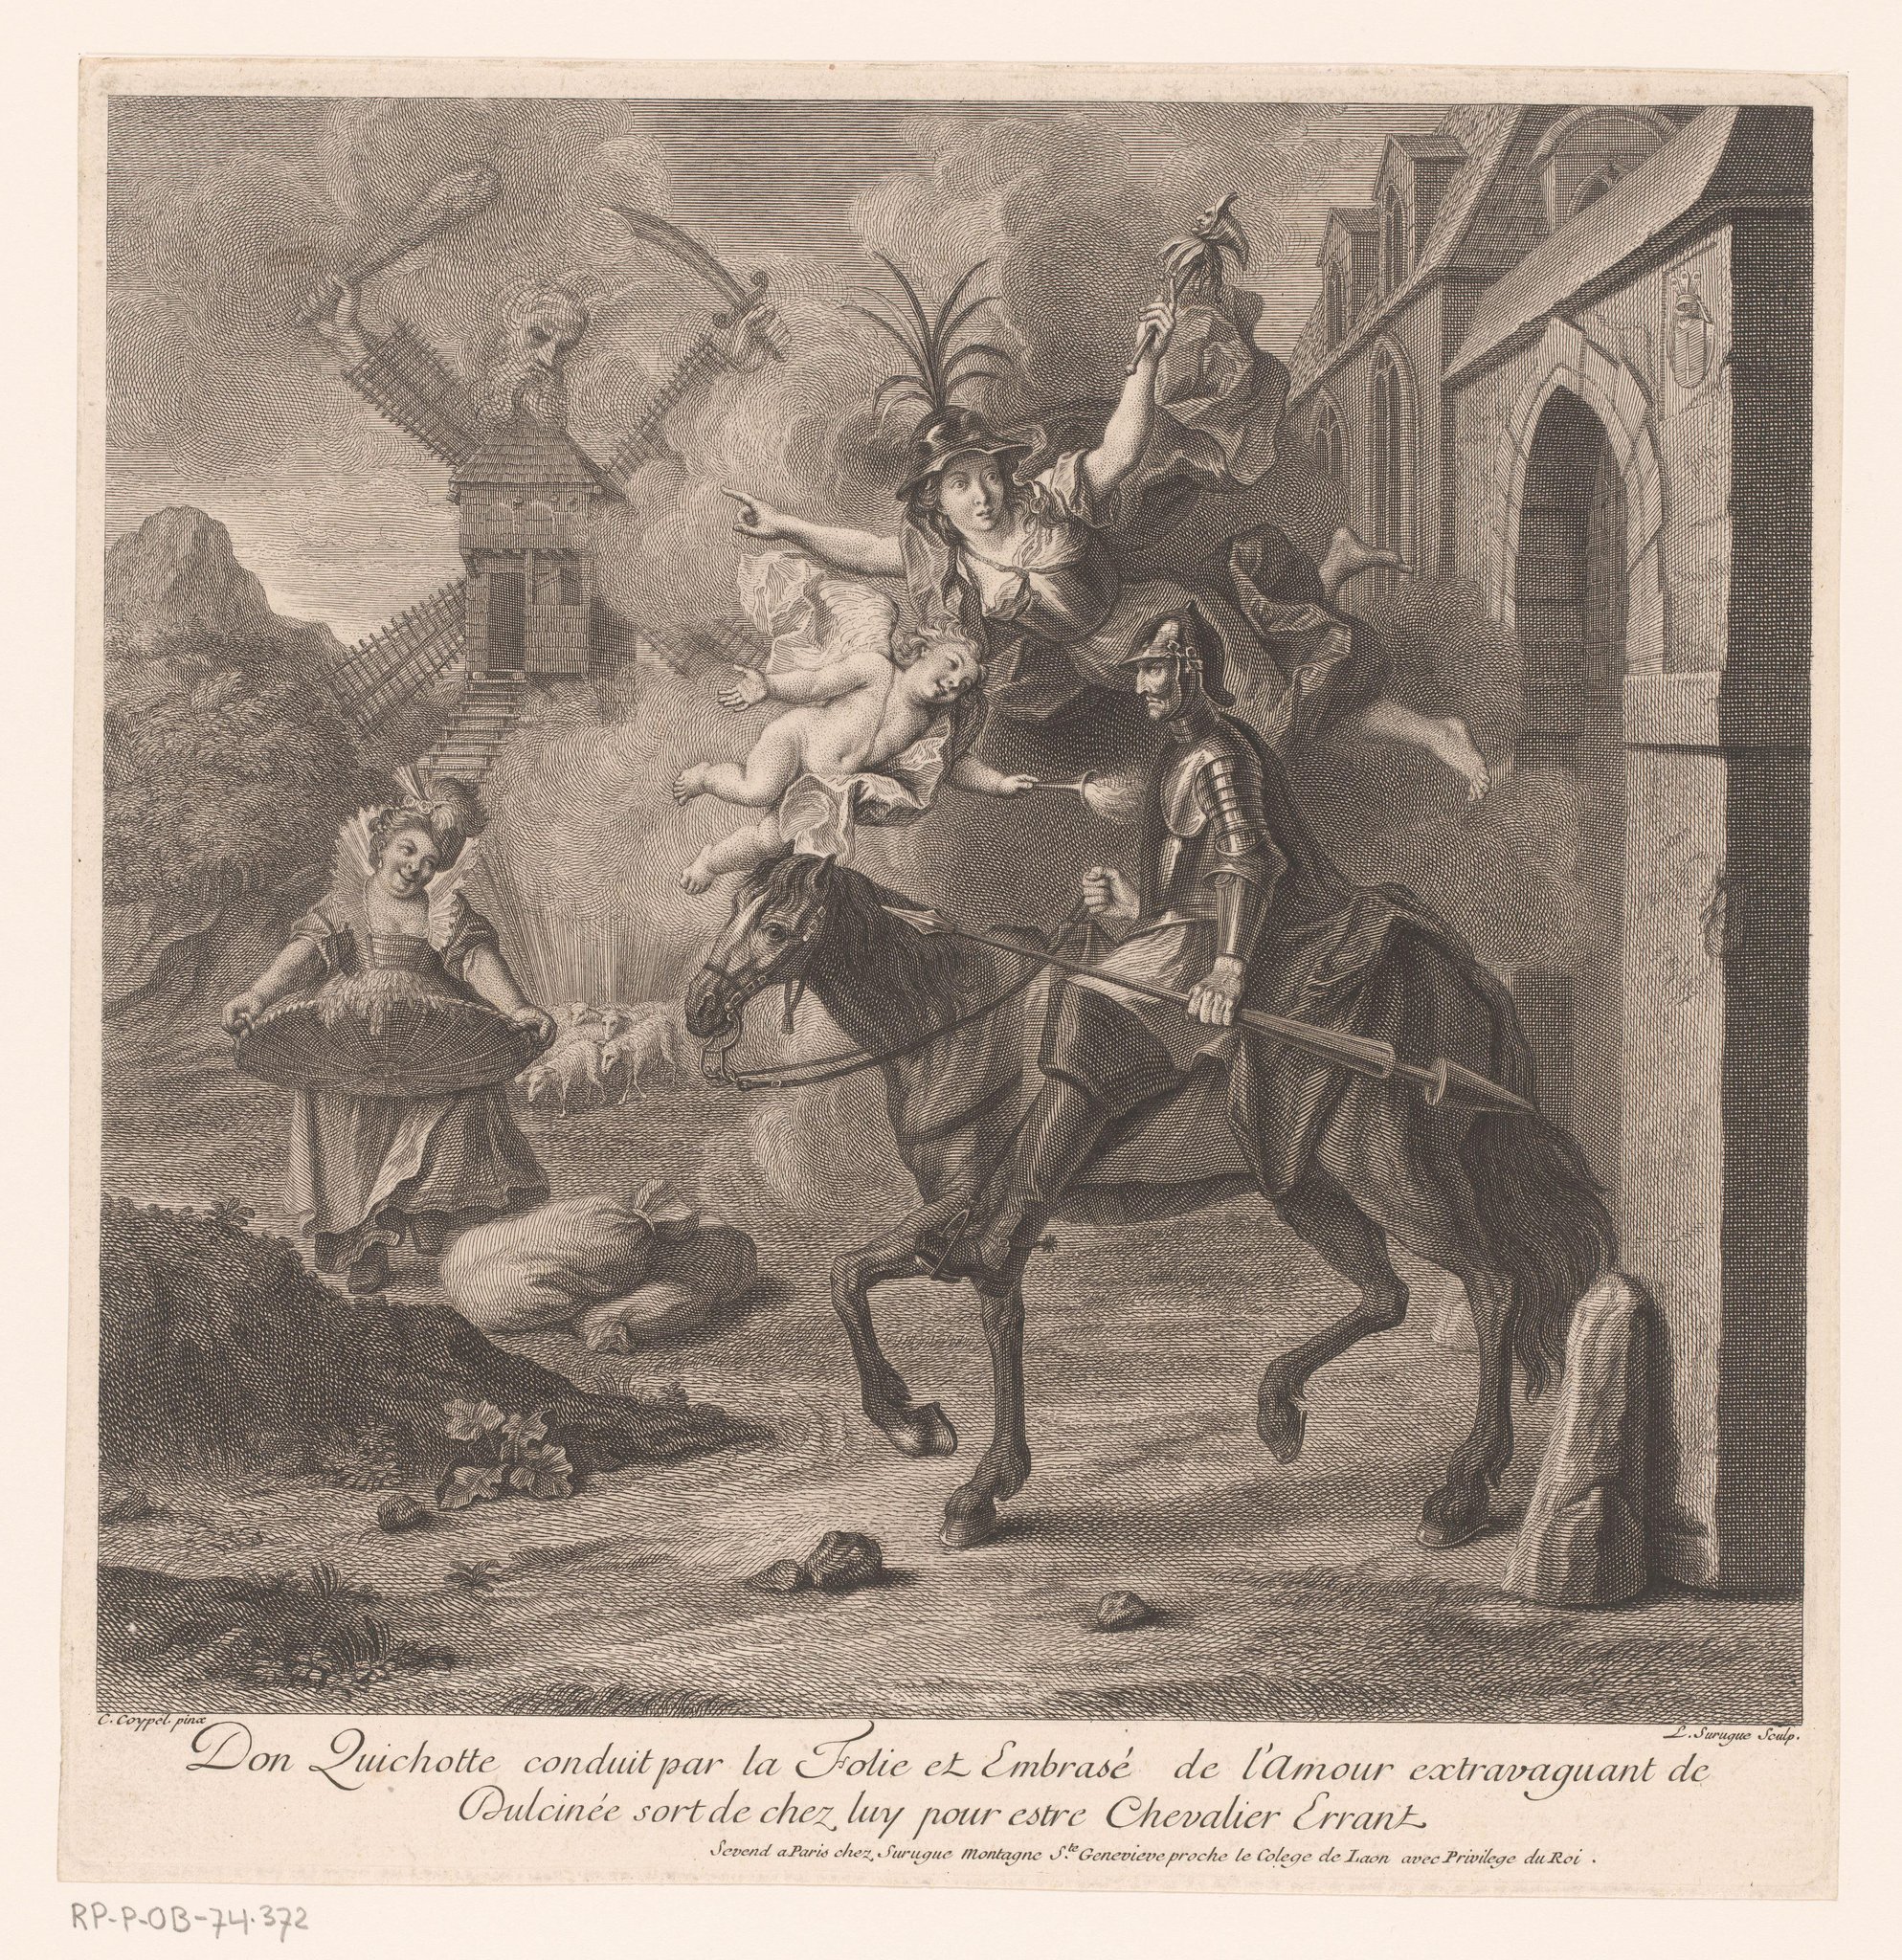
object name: print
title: Don Quichot verlaat begeleid door de Dwaasheid zijn huis om dolend ridder te worden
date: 1691-1767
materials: paper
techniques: engraving, etching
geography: france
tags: don quixote, sancho panza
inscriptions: collector's mark: Lugt 240